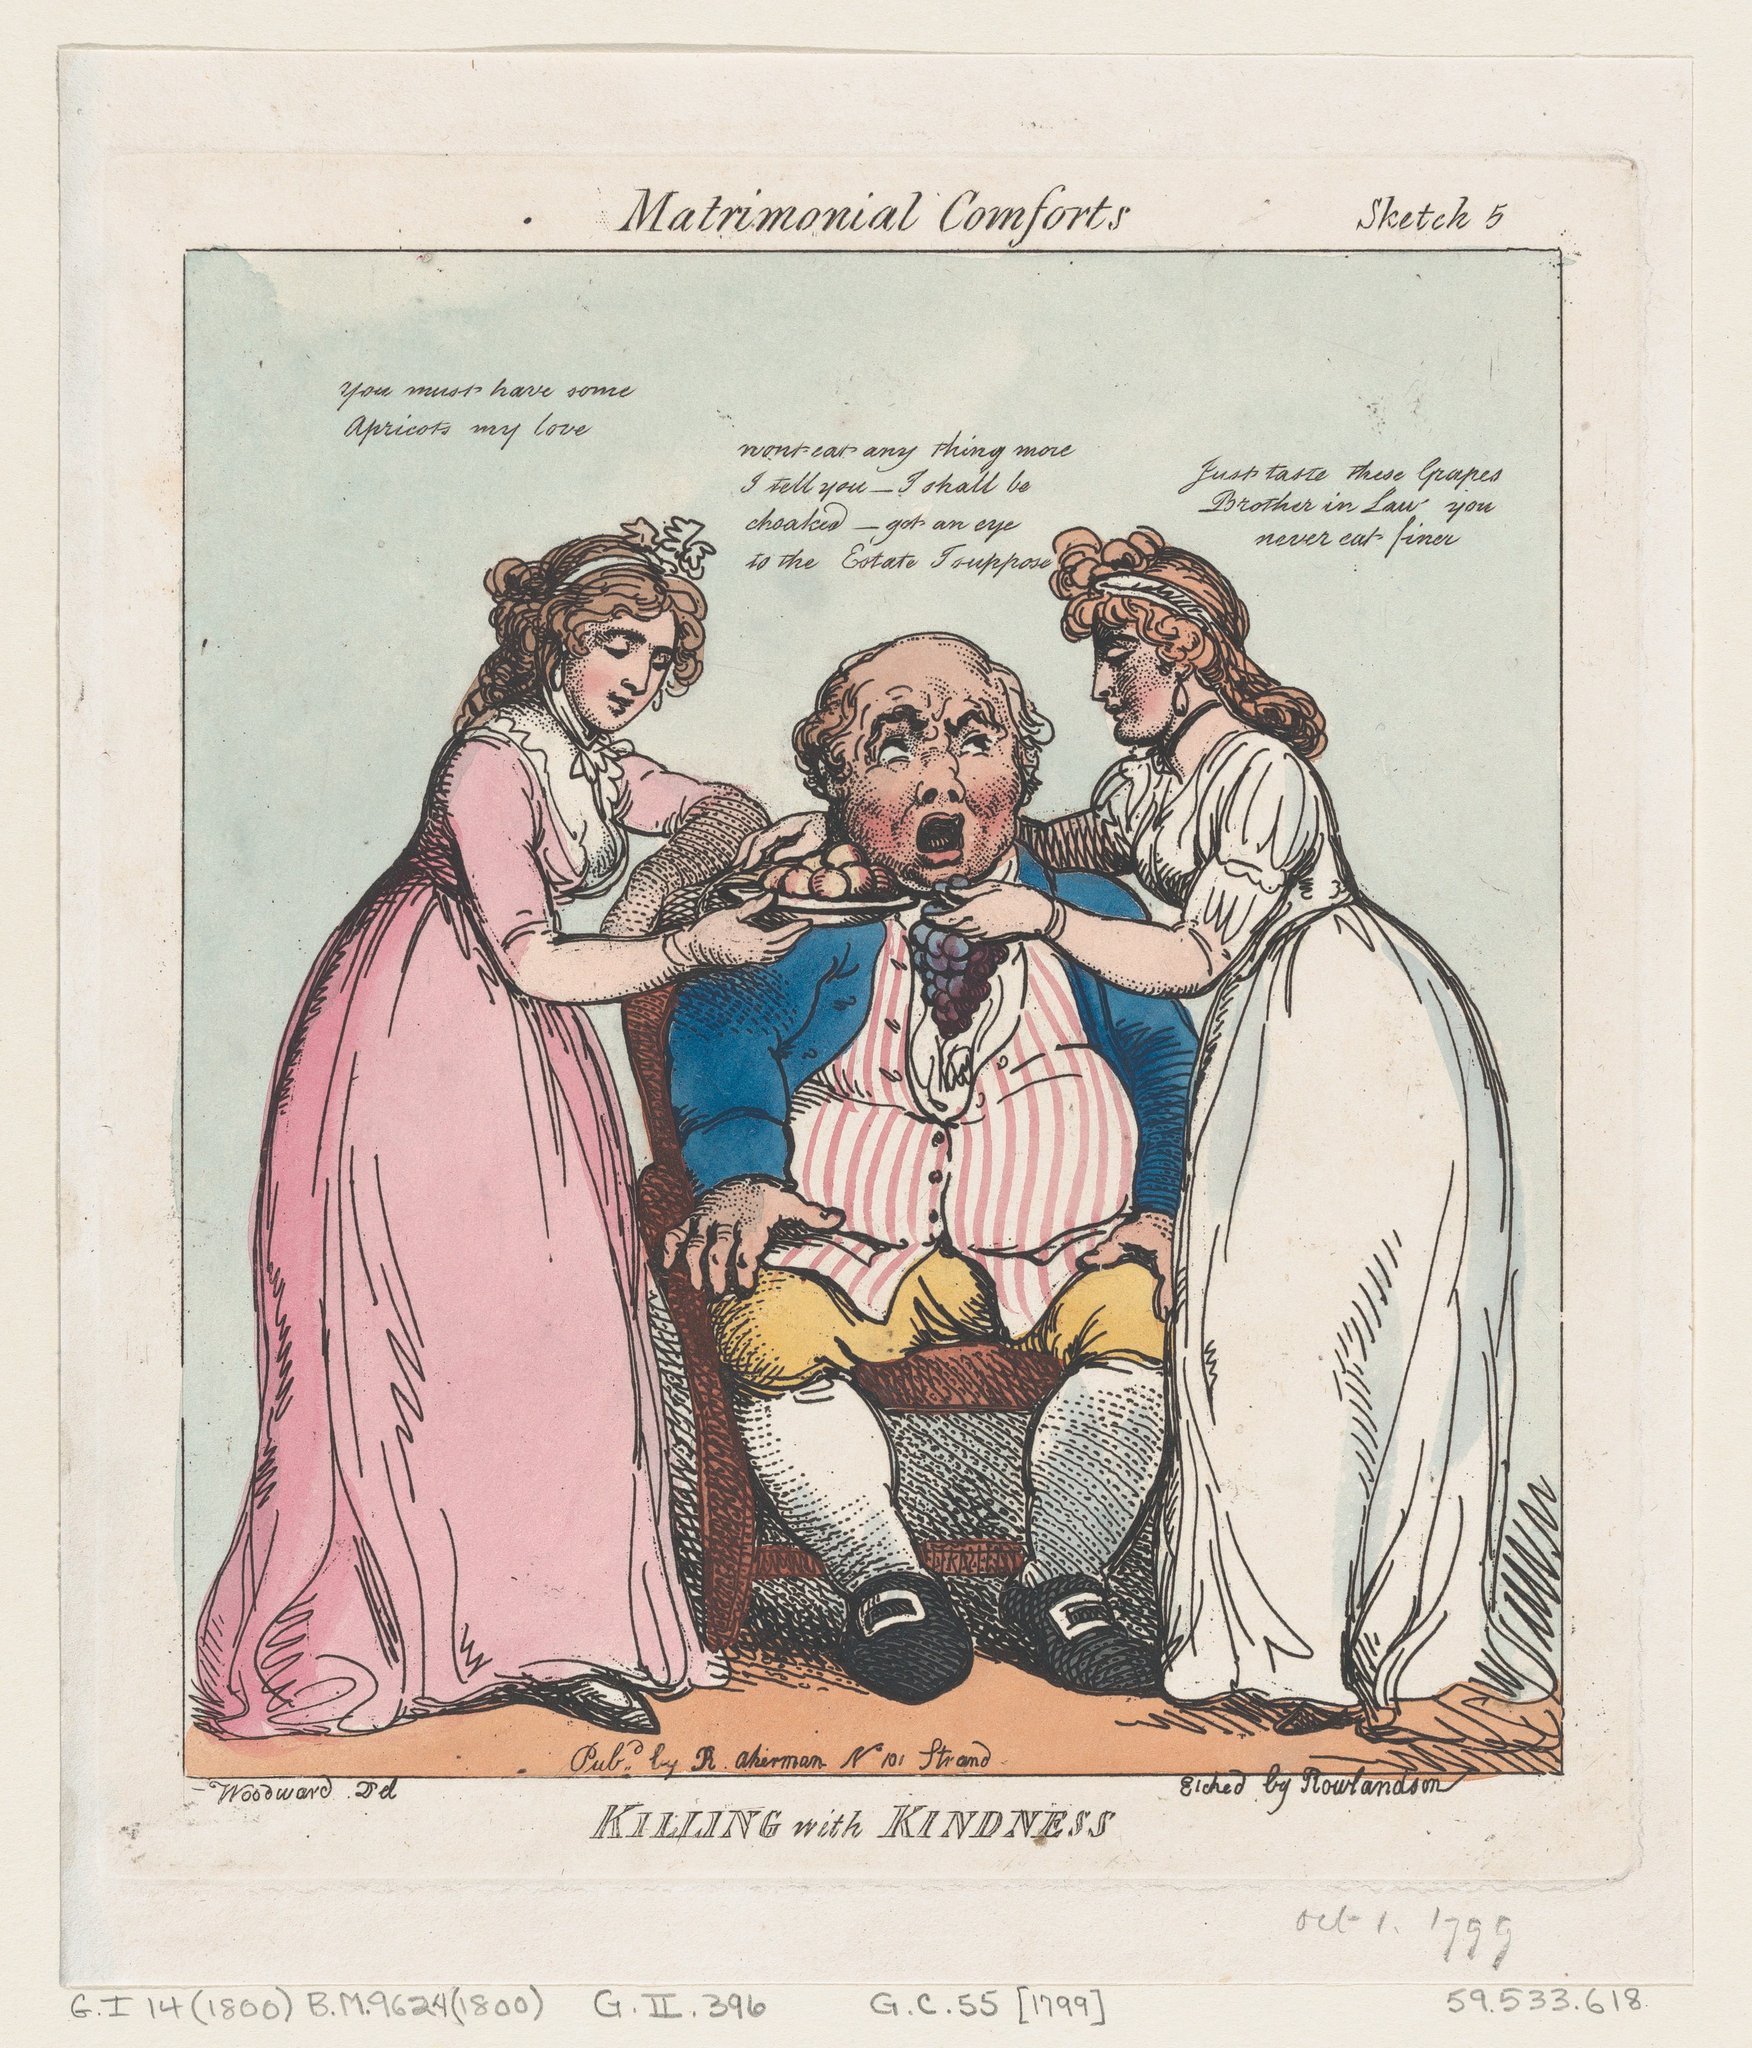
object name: print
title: Killing with Kindness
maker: thomas rowlandson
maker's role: artist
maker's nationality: british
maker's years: 1757-1827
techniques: etching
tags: men,women